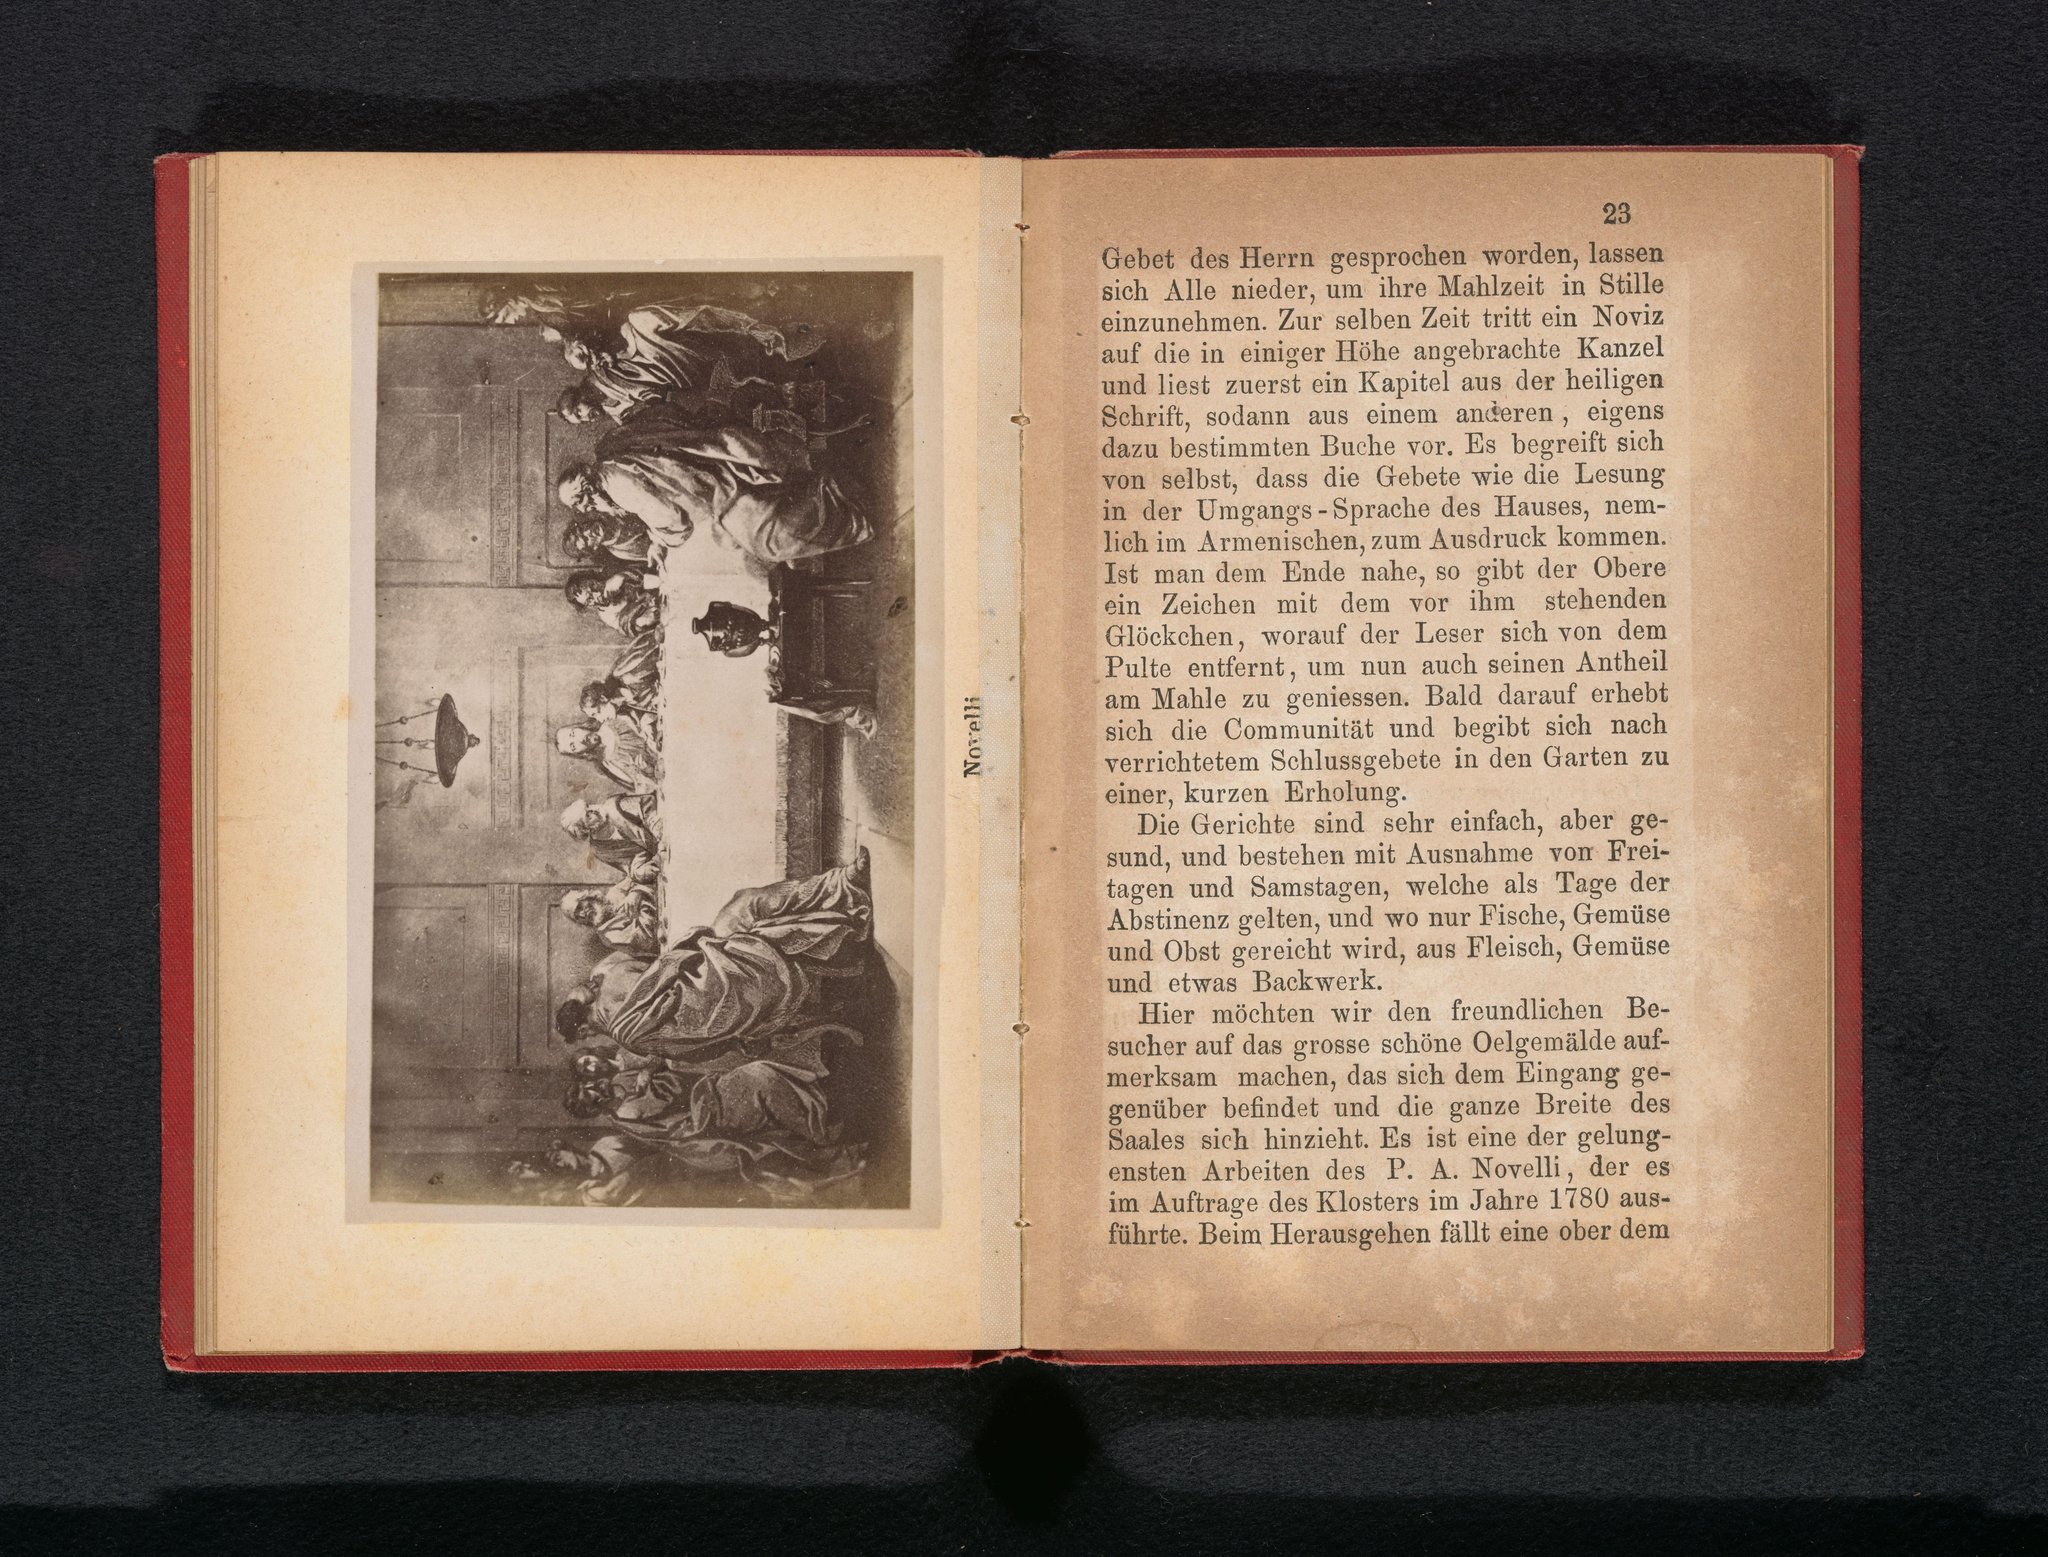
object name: reproduction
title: Novelli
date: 1870-1880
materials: paper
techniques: albumen print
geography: san lazzaro degli armeni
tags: london, lord byron, last supper (in general) (matthew 26:21-35; mark 14:18-31; luke 22:3, 22:15-23; john 13:21-38)